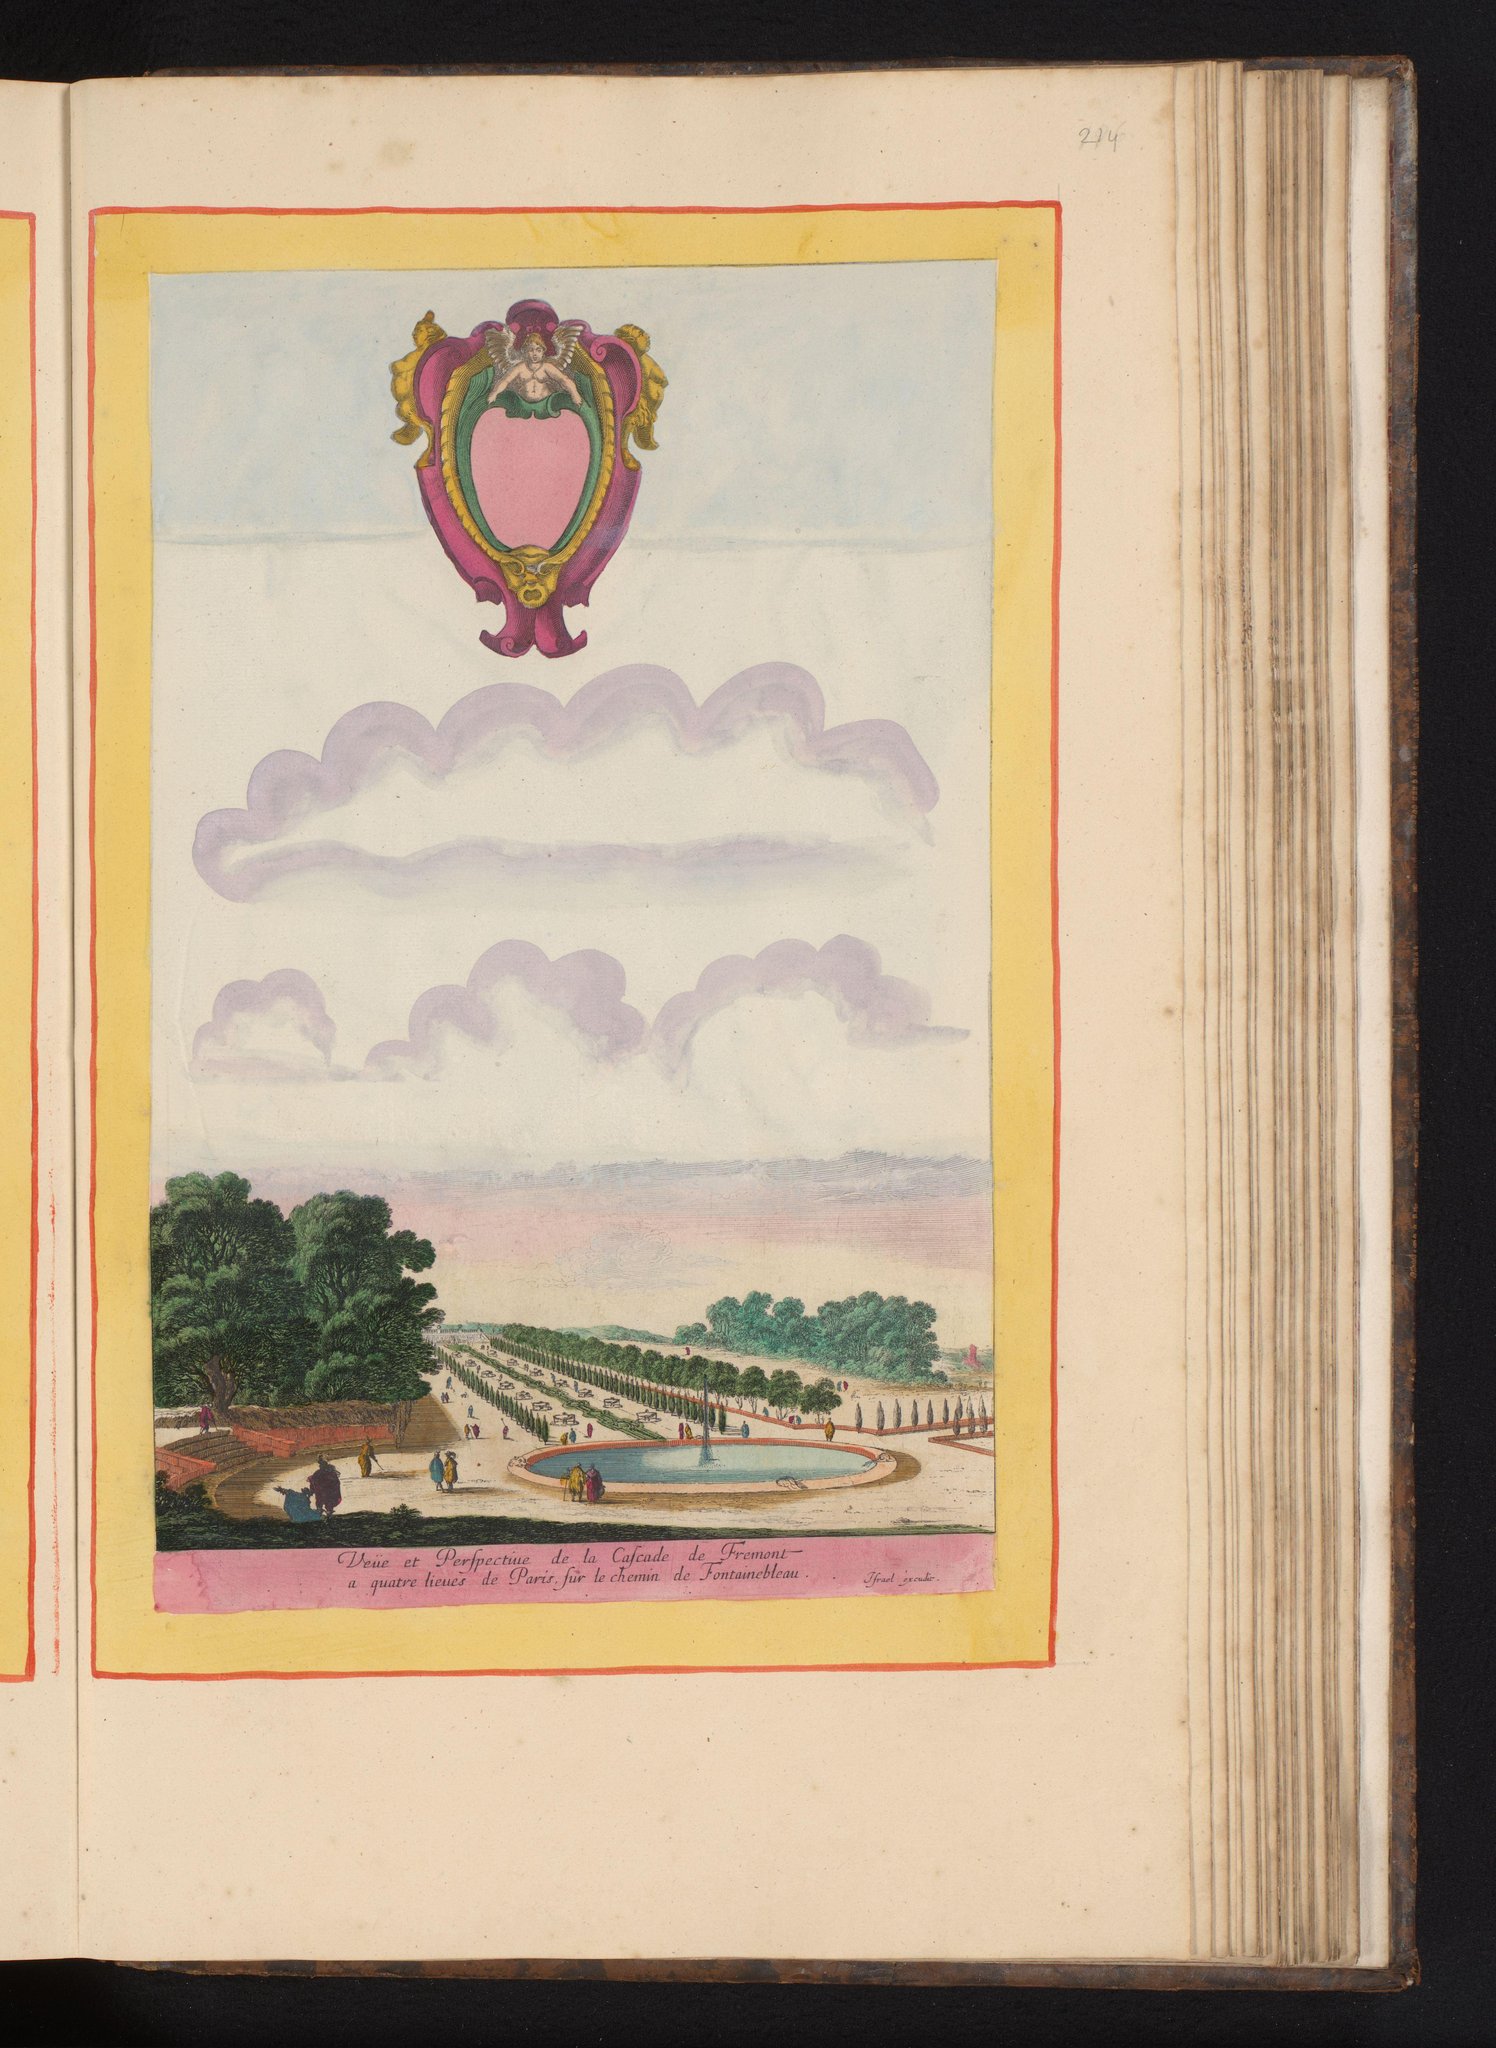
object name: album leaf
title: Gezichten op de omgeving van Parijs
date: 1631-1661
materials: paper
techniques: etching, hand coloring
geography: paris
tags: garden cascade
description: Gezicht op de fonteinen en cascades in de tuinen van Château de Fromont te Ris-Orangis aan de weg van Parijs naar Fontainebleau. In de lucht een ornamenteel leeg wapenschild. Prent maakt deel uit van een album.